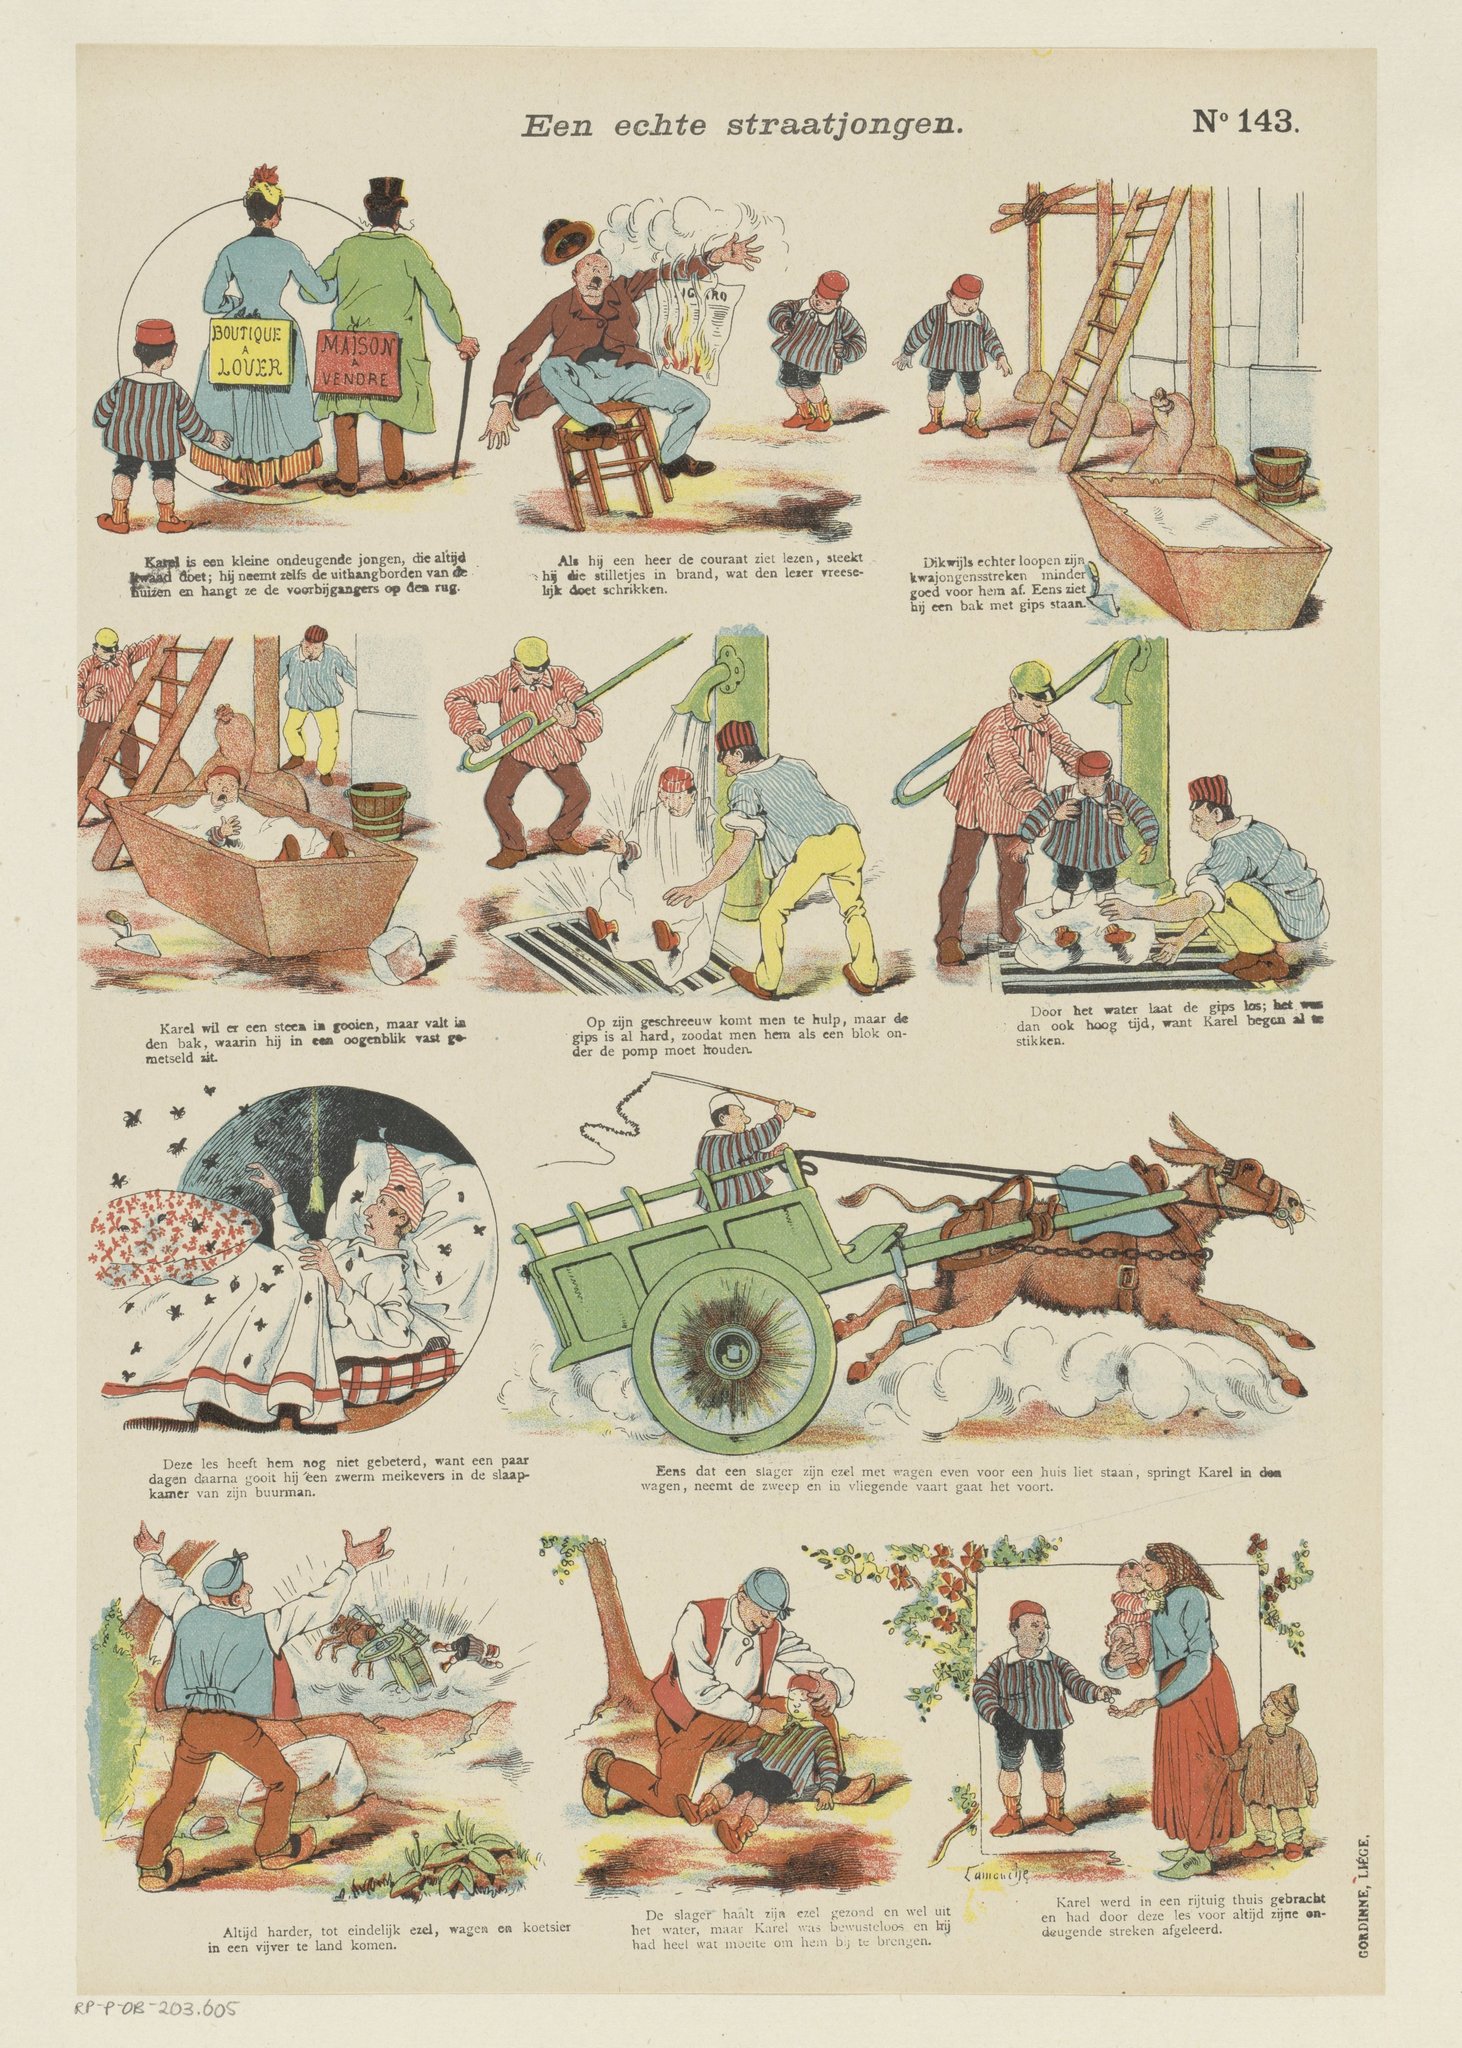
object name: popular print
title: Een echte straatjongen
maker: lamouche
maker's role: print maker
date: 1894-1959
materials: paper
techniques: lithograph, letterpress printing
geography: liège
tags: mischief-making play, child, bad behaviour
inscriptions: collector's mark: Lugt 2760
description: Blad met 11 voorstellingen over de kwajongen Karel die verschillende streken uithaalt. Onder elke afbeelding een onderschrift. Genummerd rechtsboven: No 143.